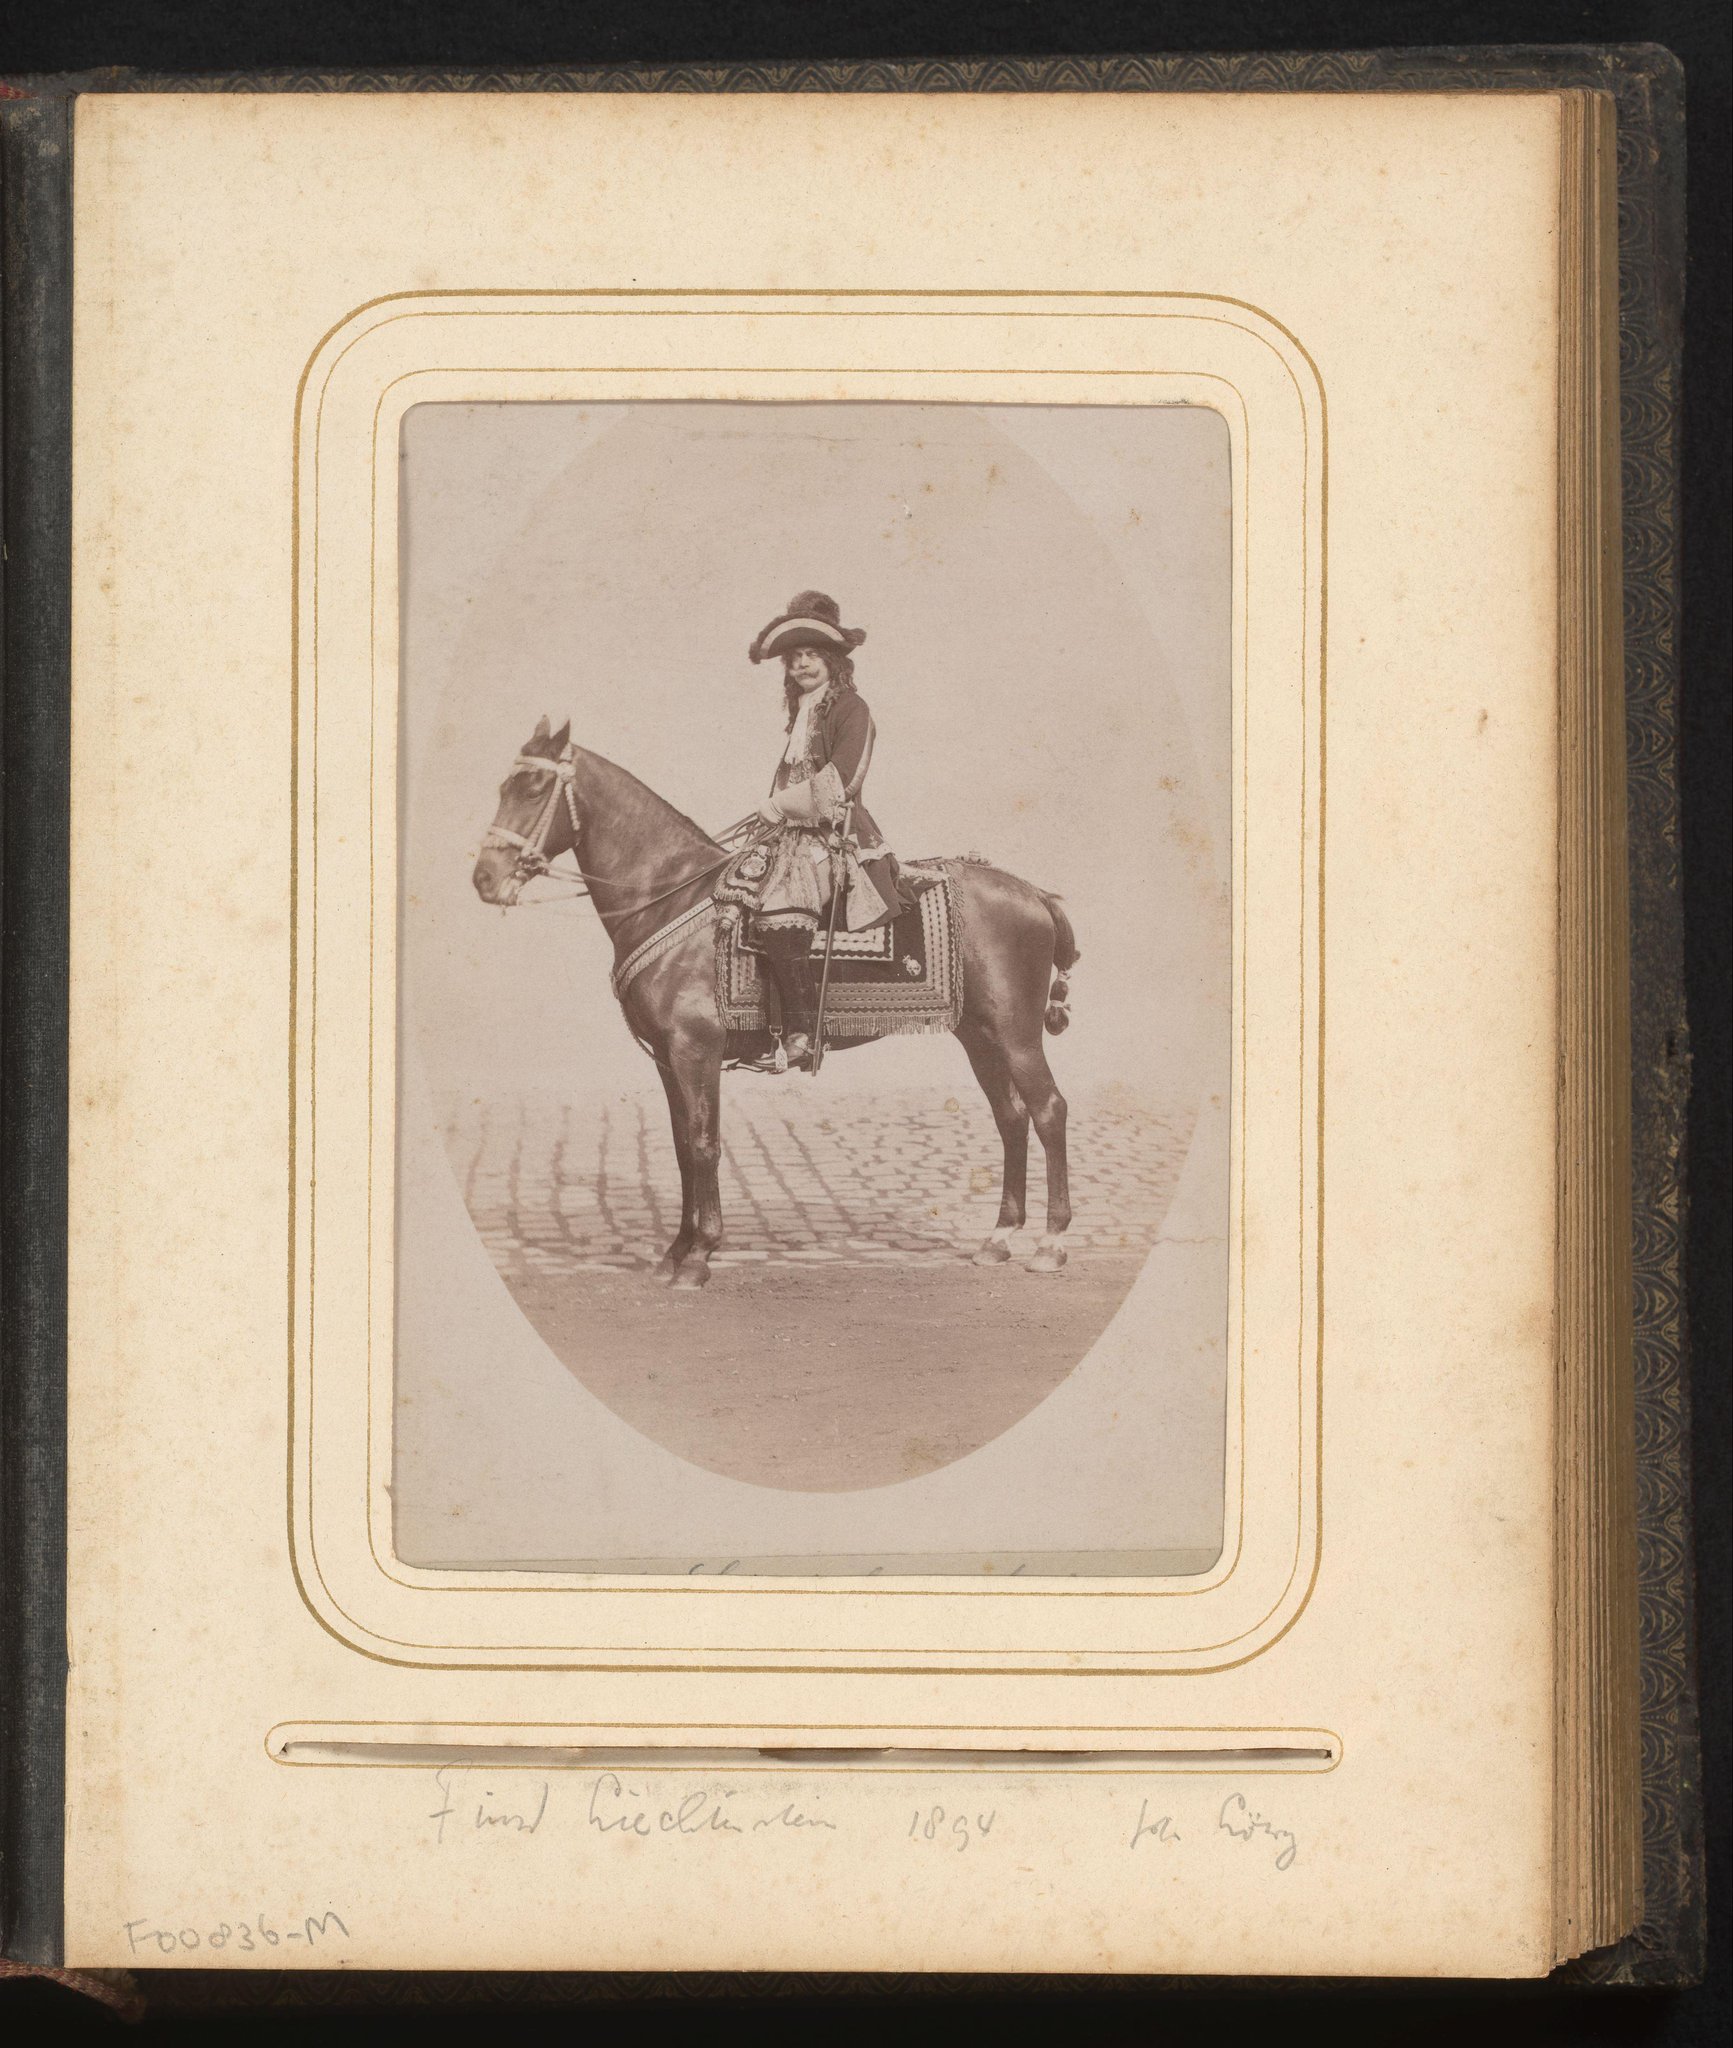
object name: photograph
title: Portret van vermoedelijk Johannes II van Liechtenstein te paard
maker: josef löwy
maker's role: publisher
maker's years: 1835-1902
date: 1894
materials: cardboard, photographic support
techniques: collodion silver print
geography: vienna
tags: riding a horse, ass, or mule; rider, horseman, historical persons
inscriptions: annotation: ‘Fürst Liechtenstein 1894/ foto Löwy’